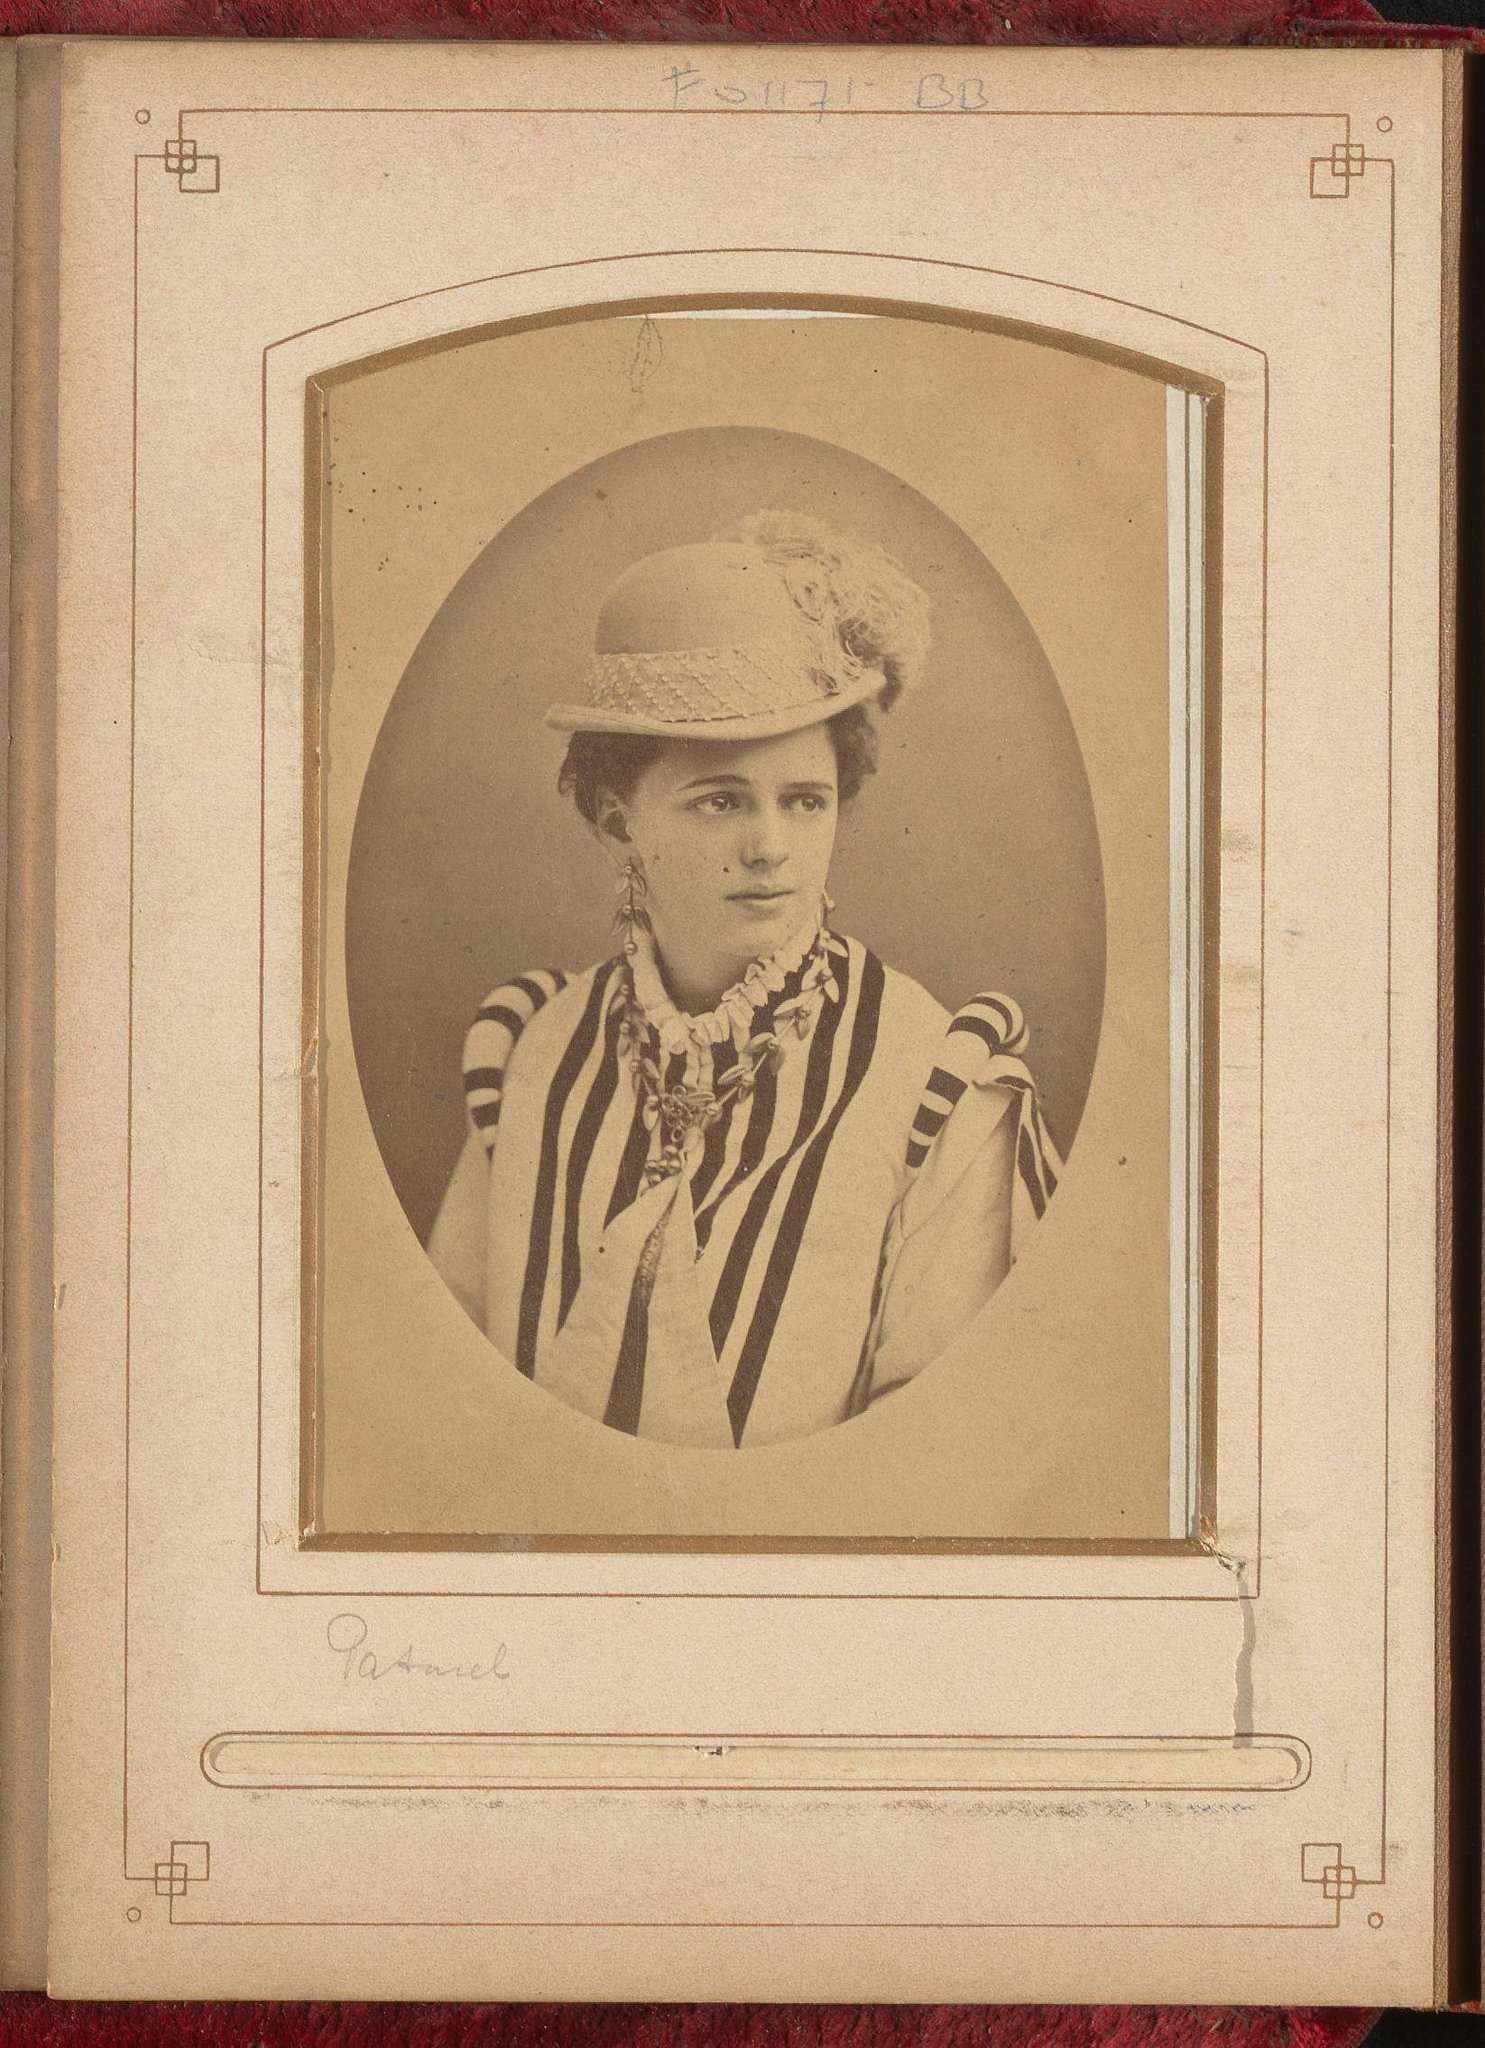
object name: cabinet photograph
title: Portret van Paturel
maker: Anonymous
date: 1880-1910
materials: cardboard, photographic support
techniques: albumen print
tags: adult woman, head-gear: hat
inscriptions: name: ‘Paturel’